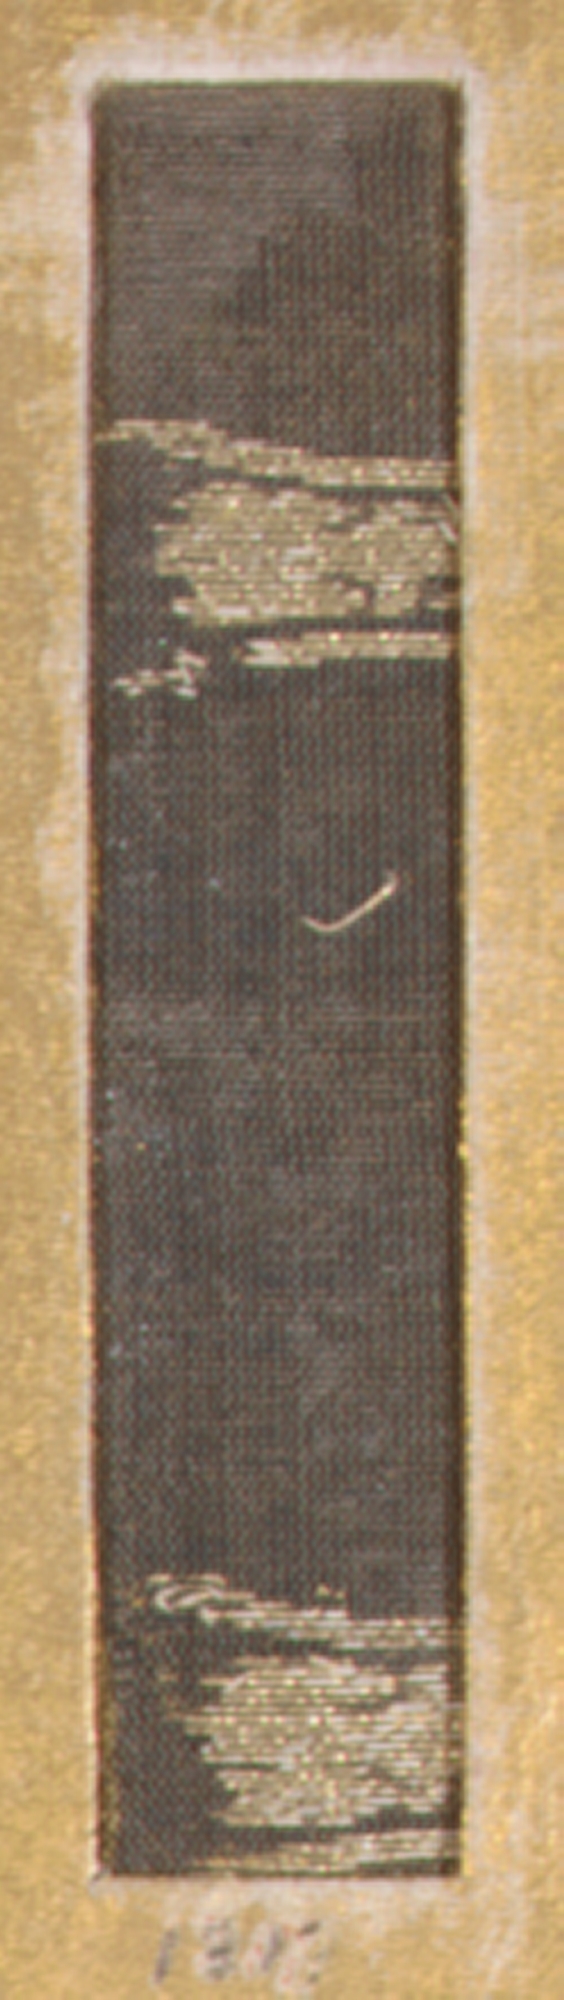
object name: piece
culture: japanese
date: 1701-1900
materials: silk